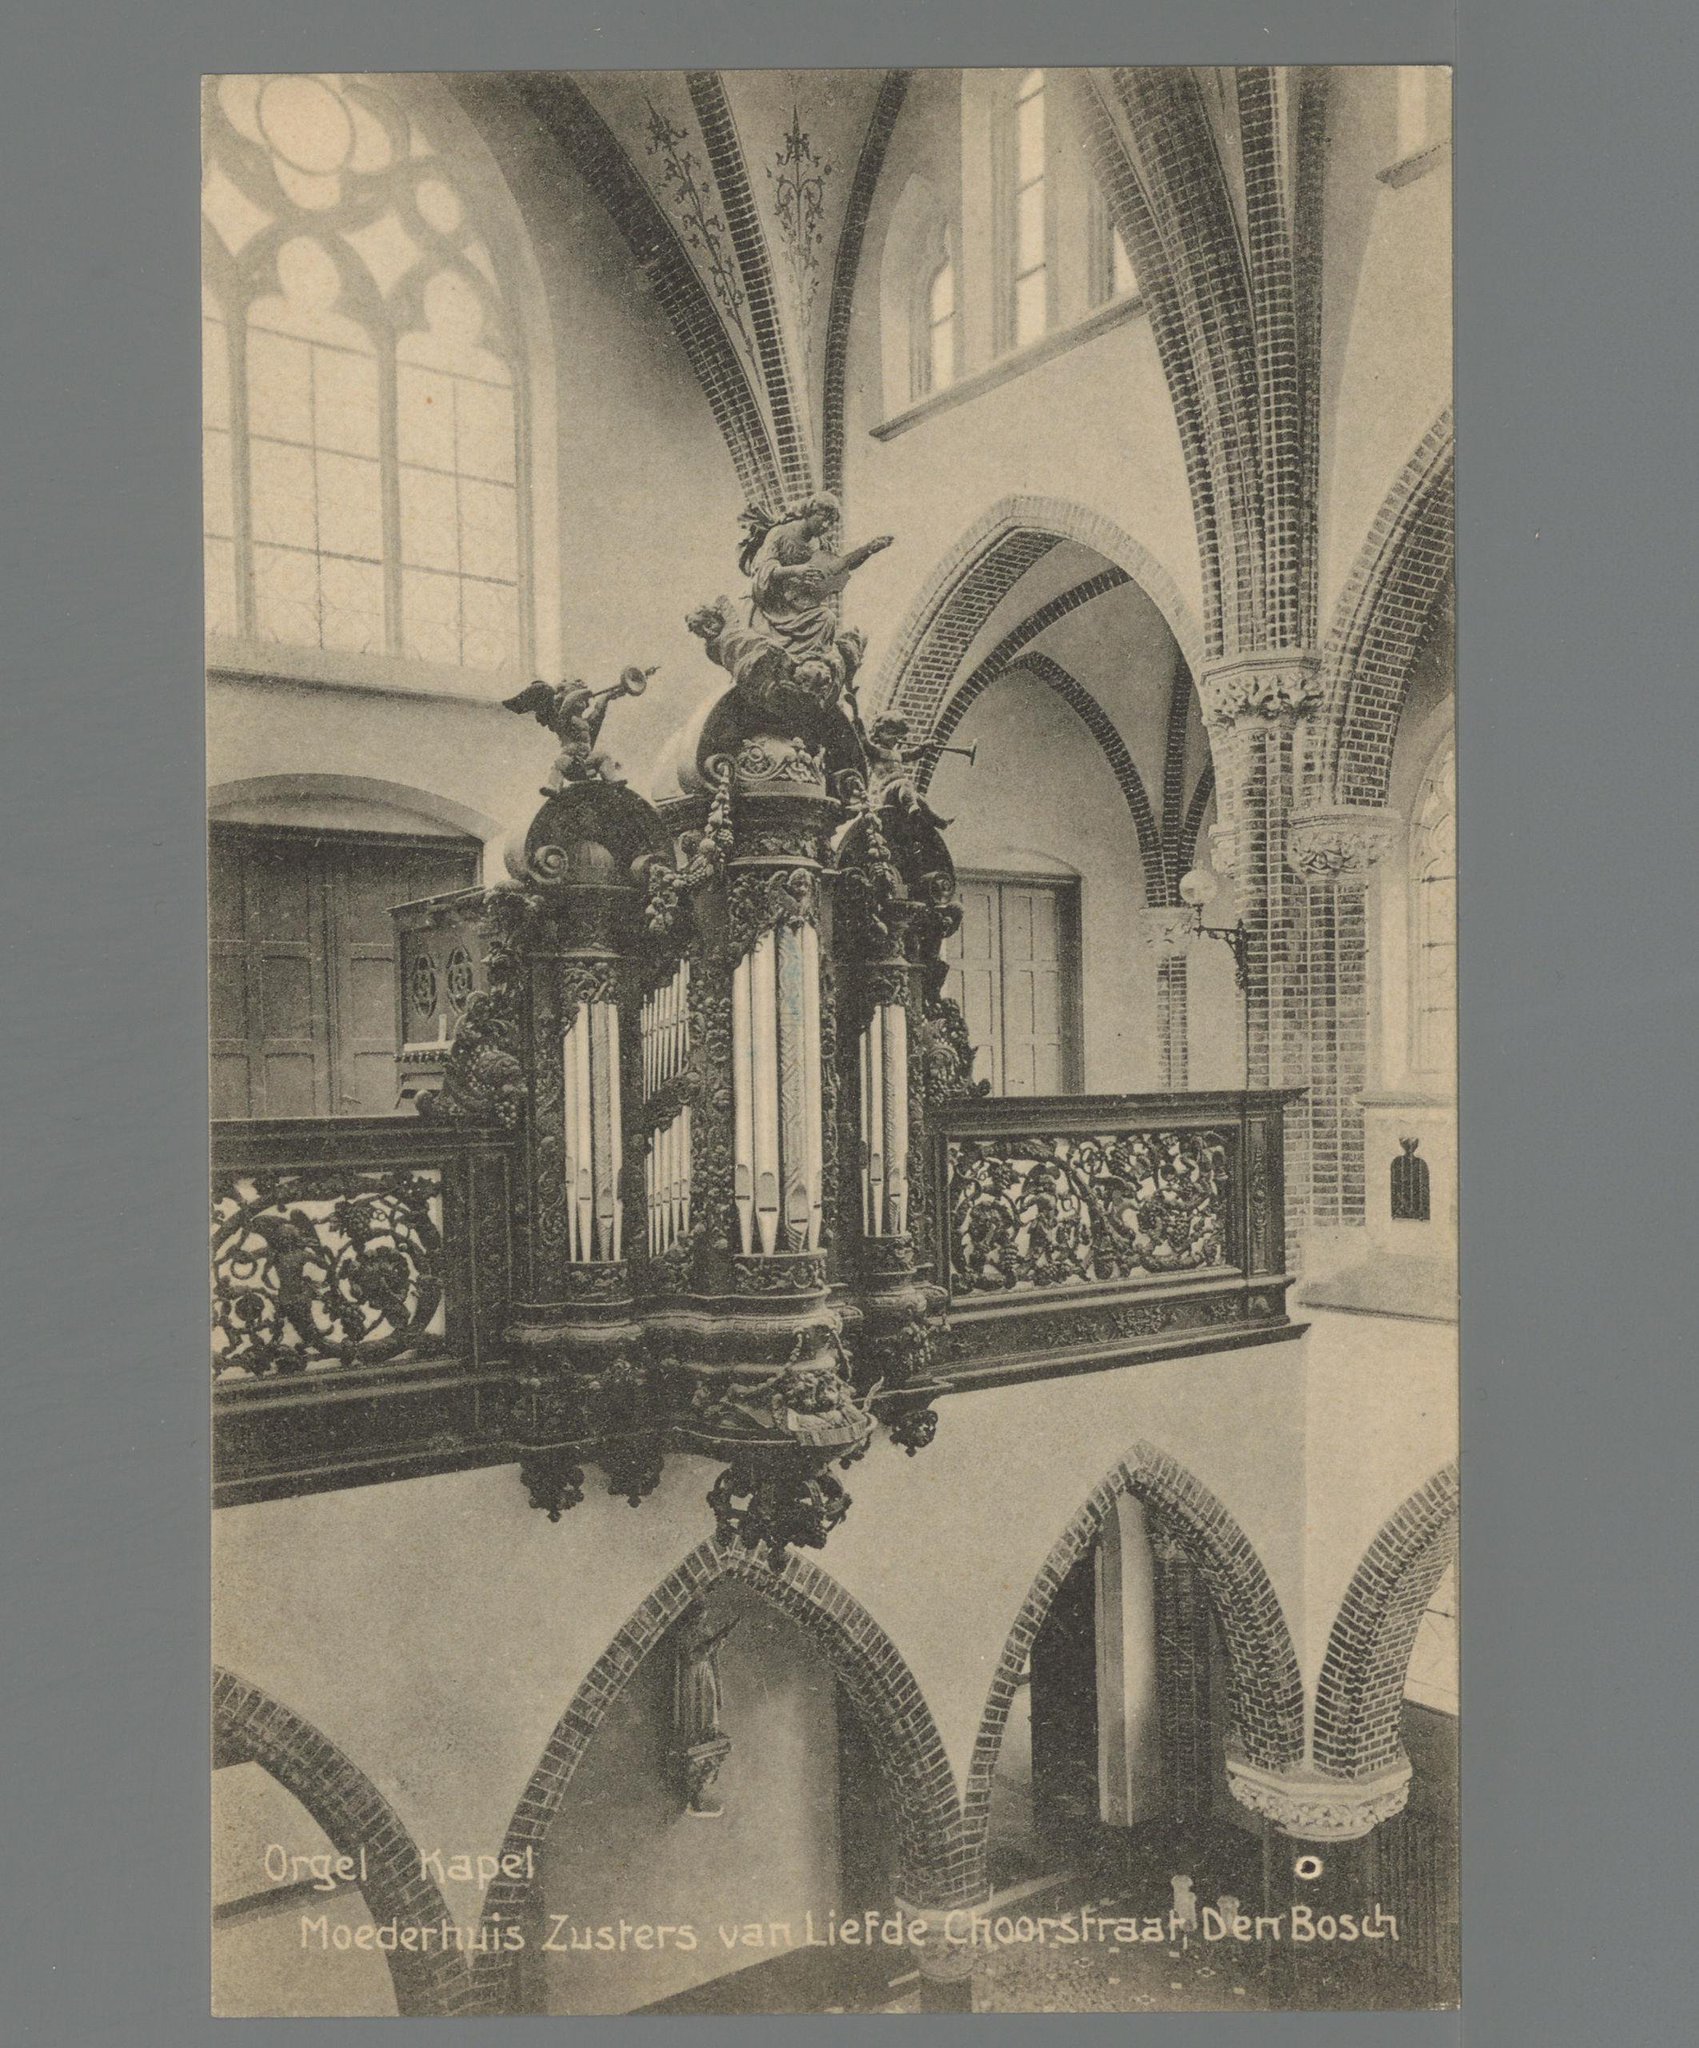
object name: photomechanical print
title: Orgel. Kapel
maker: Anonymous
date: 1908-1930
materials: cardboard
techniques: photograph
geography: den bosch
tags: church organ, interior of church, parts of church interior: chapel, den bosch